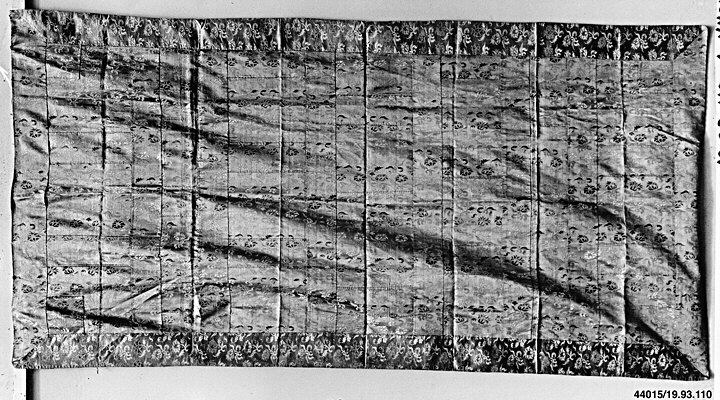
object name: robe, priest's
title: Priest's Robe (Shichijô)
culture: japanese or dutch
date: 1650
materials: silk